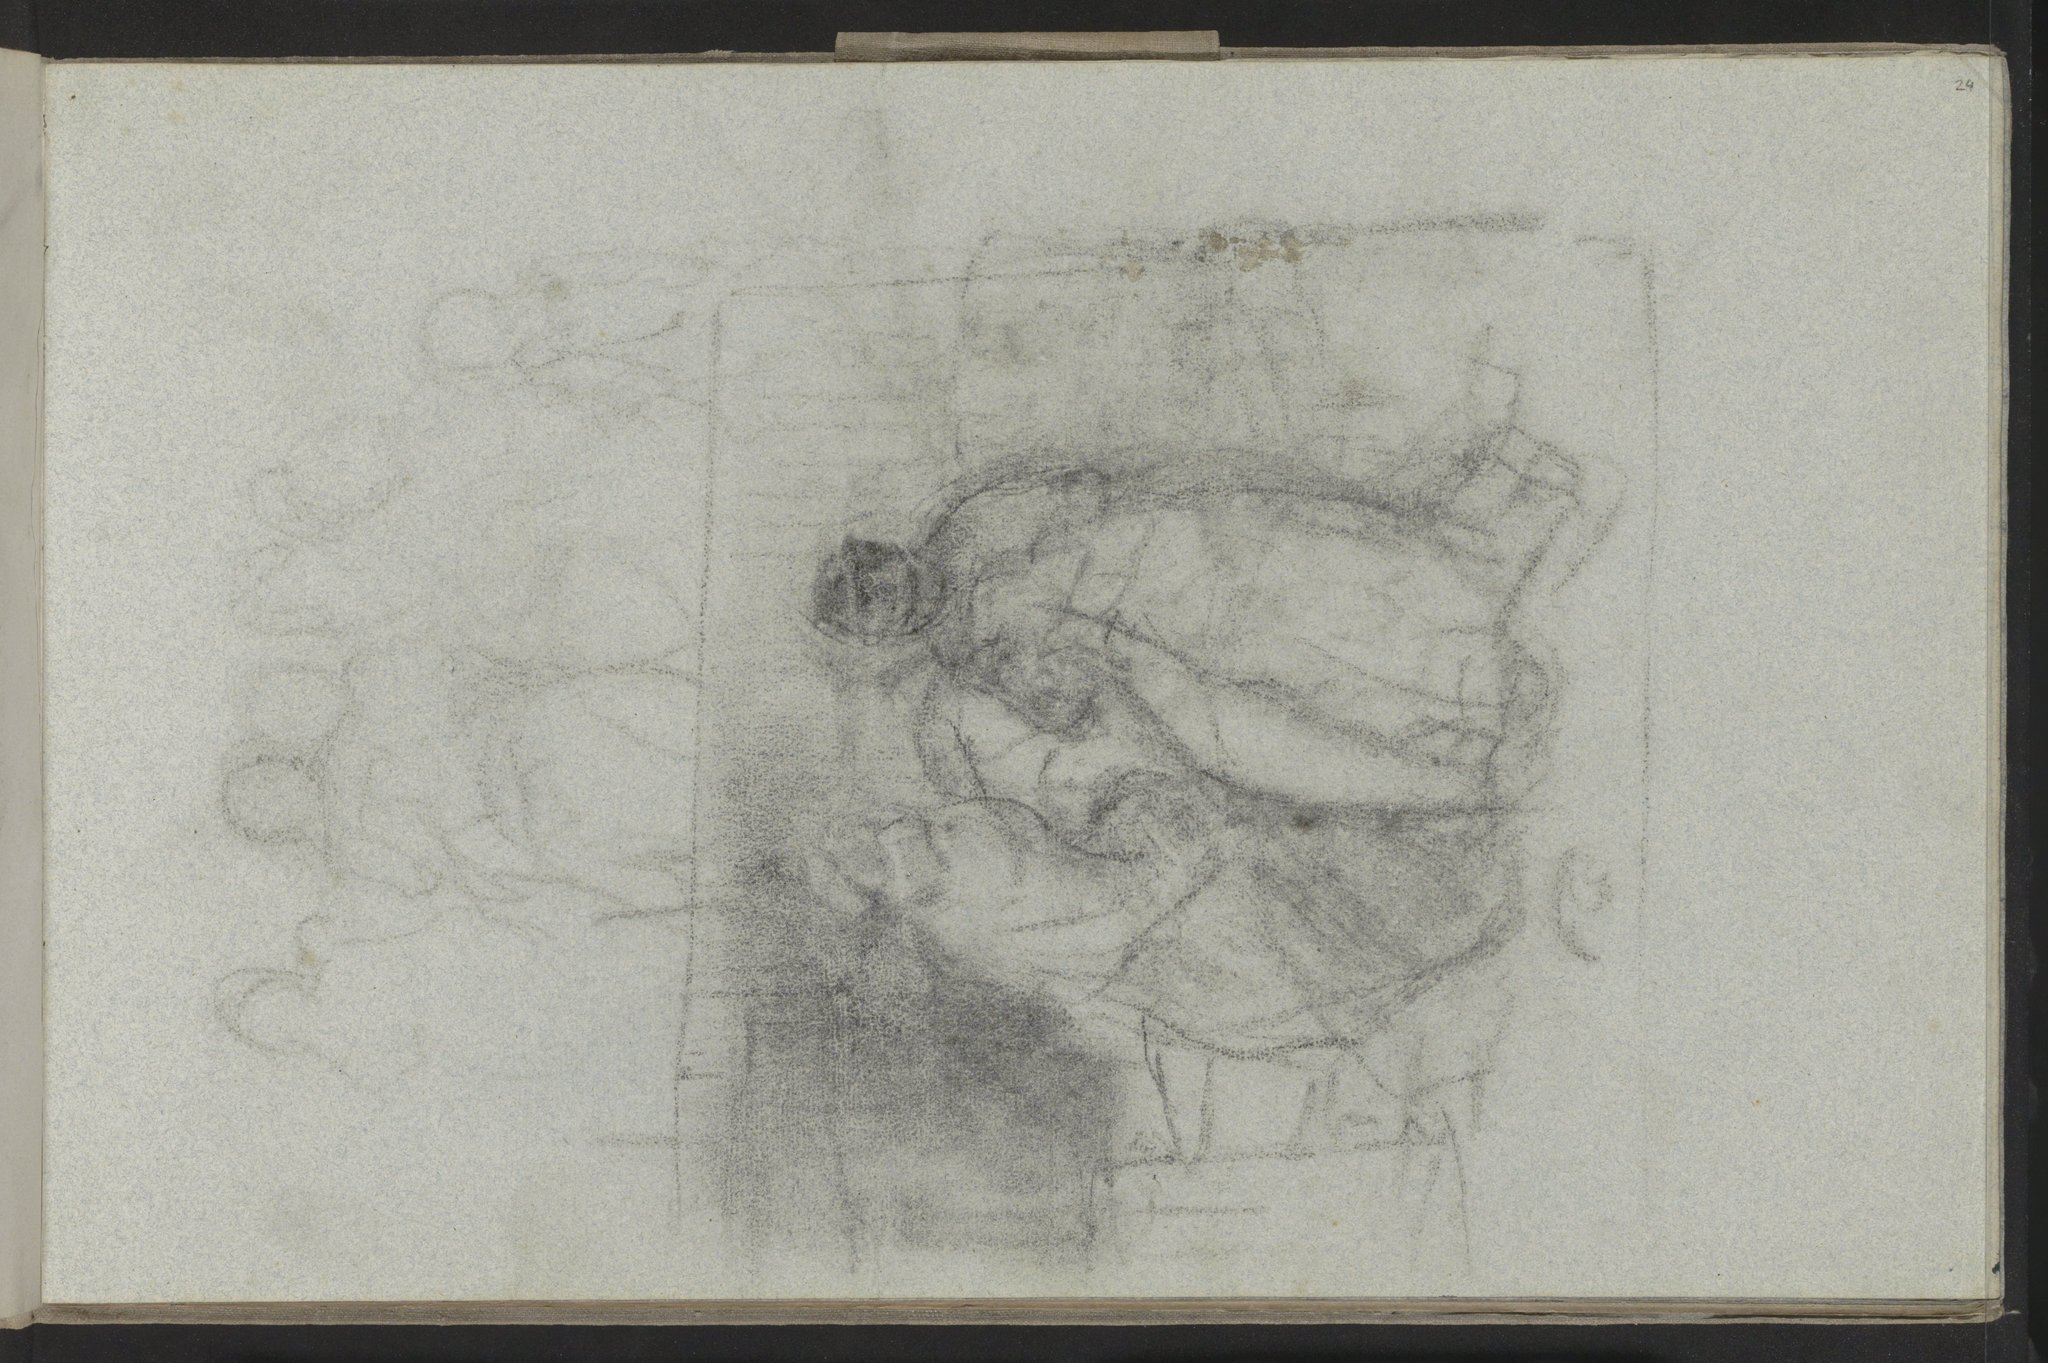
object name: sketchbook leaf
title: Twee zittende vrouwen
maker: albert neuhuys (1844-1914)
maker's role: draughtsman, painter, print maker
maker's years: 1844-1914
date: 1854-1914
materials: charcoal, paper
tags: sitting figure, adult woman, home sewing; repair of clothes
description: Eén van de vrouwen is aan het handwerken, de ander buigt zich naar haar toe. Tevens een studie van een groep vrouwen. Blad 24 recto uit een schetsboek met 51 bladen.